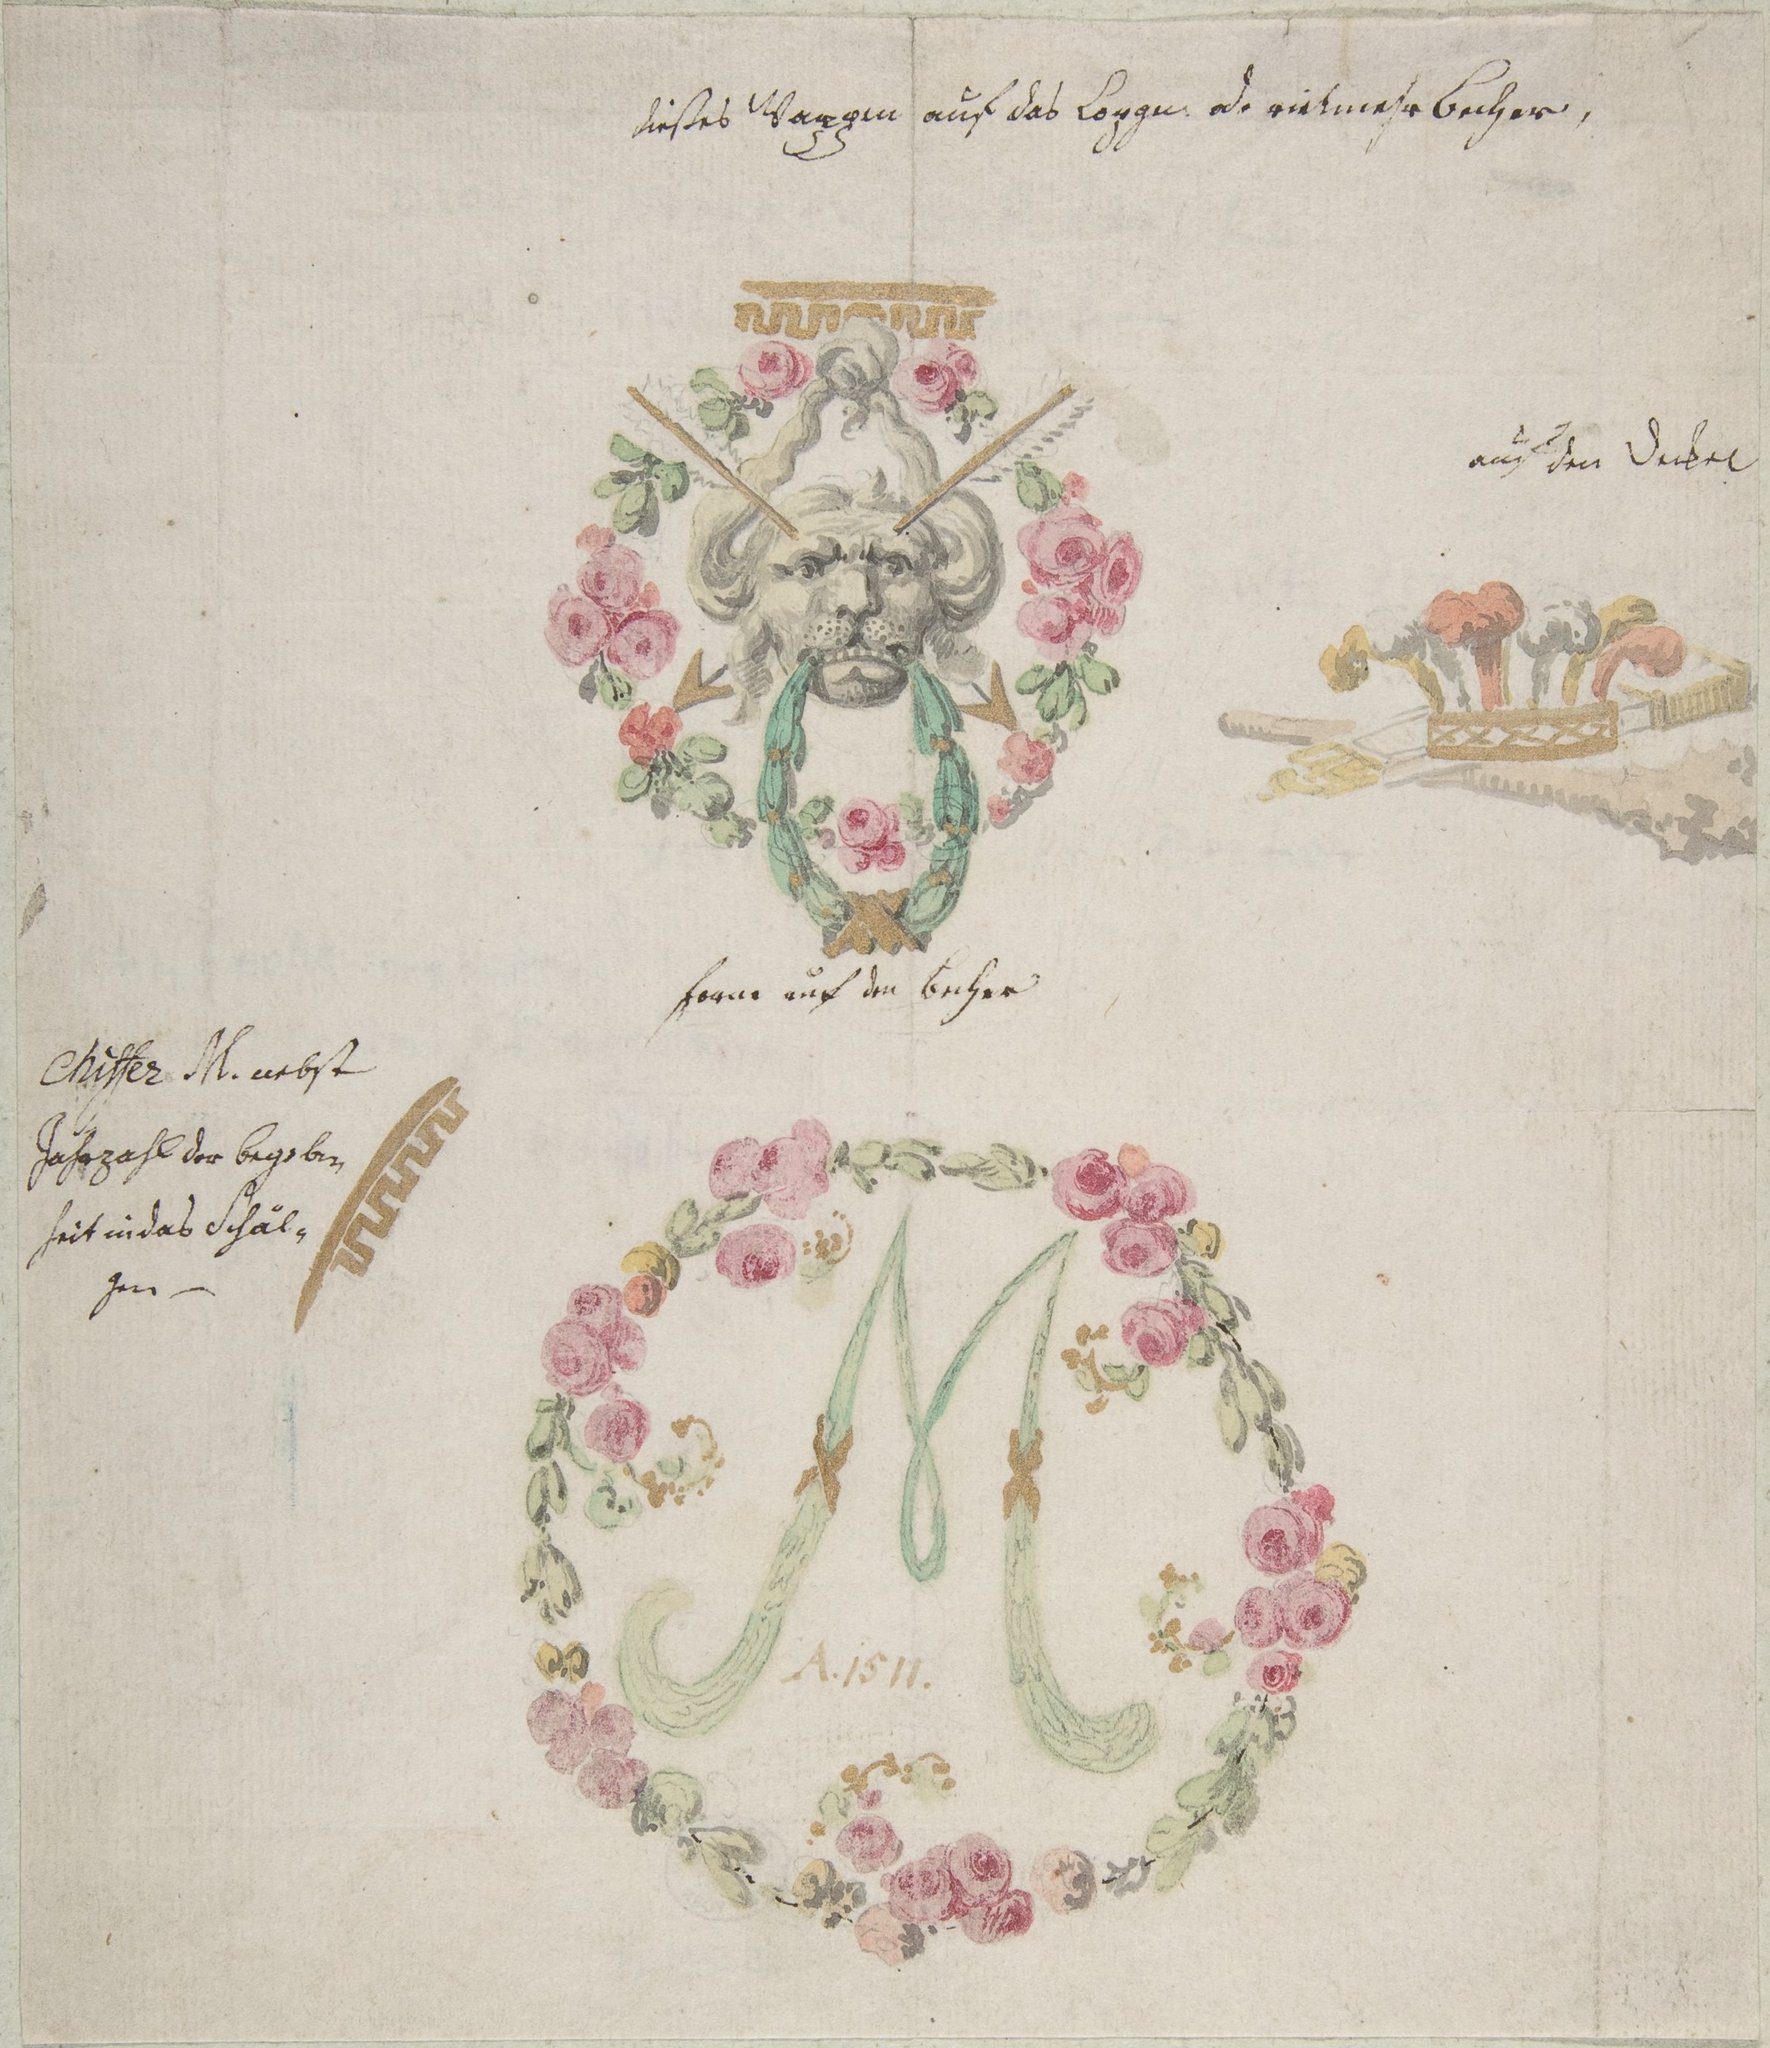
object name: drawing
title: Ornamental designs for porcelain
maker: anonymous, german, 18th century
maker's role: artist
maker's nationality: german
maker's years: 1700-1800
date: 1701-1800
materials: graphite, watercolor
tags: garlands,ornament,insignia